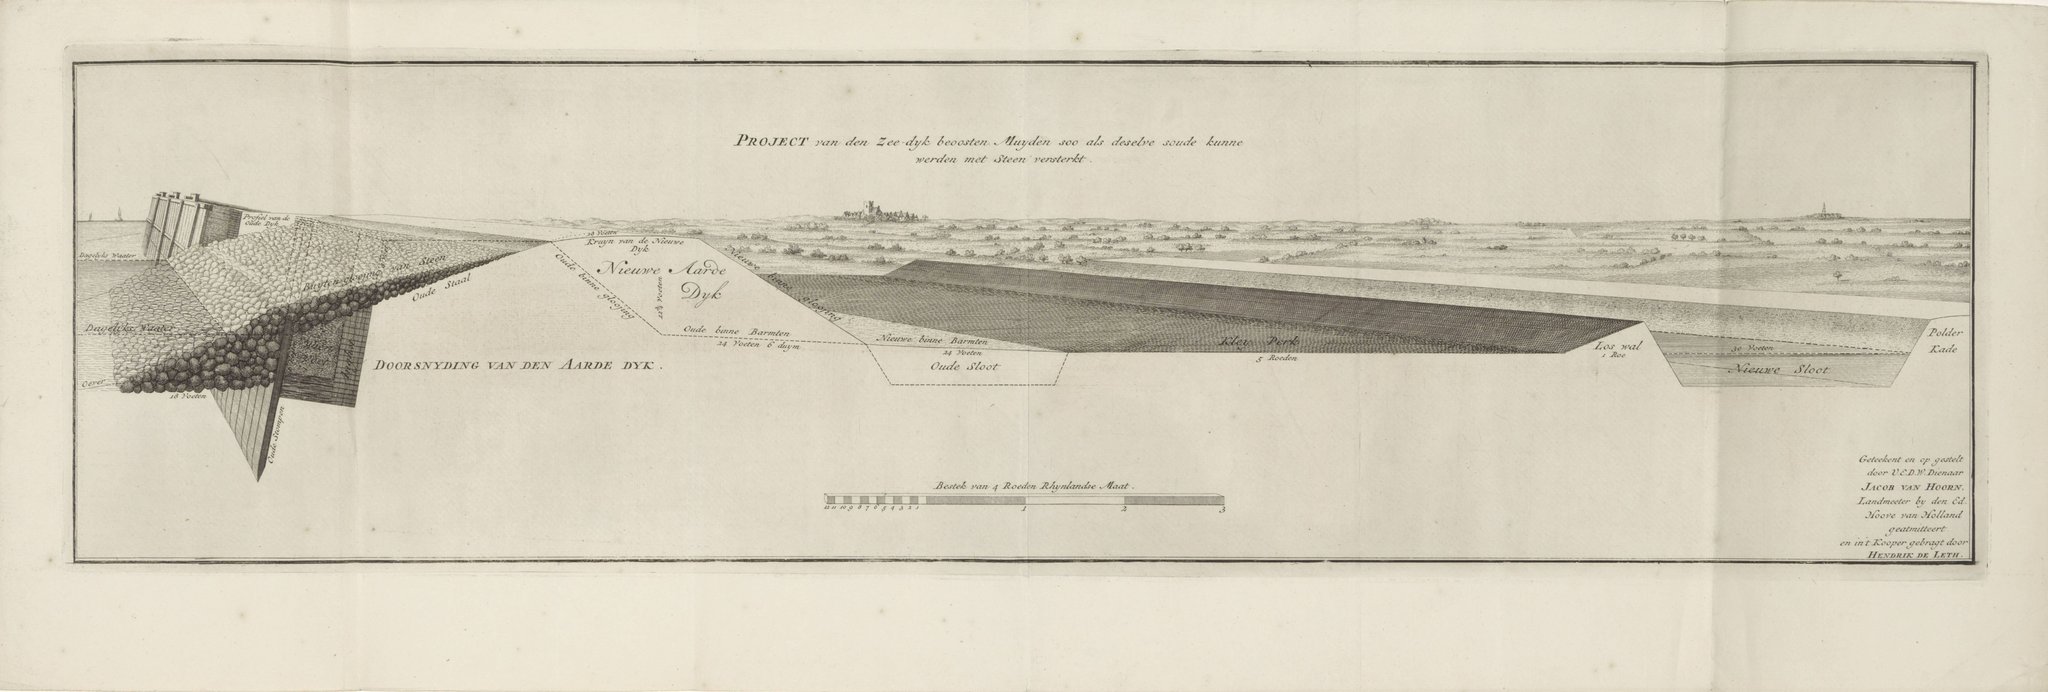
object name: print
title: Project van den zee-dyk beoosten Muyden soo als deselve soude kunne werden met steen versterkt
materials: paper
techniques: engraving, etching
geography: amsterdam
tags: engineering, dikes, levee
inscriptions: collector's mark: Lugt 2228, collector's mark: Lugt 2760, collector's mark: Lugt 2166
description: Ontwerptekening van een nieuwe stenen constructie voor de zeedijk ten oosten Muiden. Met doorsnede van de dijk en het achter de dijk gelegen land, voorzien van bijschriften. Onderaan in het midden een schaalstok: Bestek van 4 roeden Rhynlanse maat. De versterkingen zouden in 1735, 1736 en 1737 worden uitgevoerd.